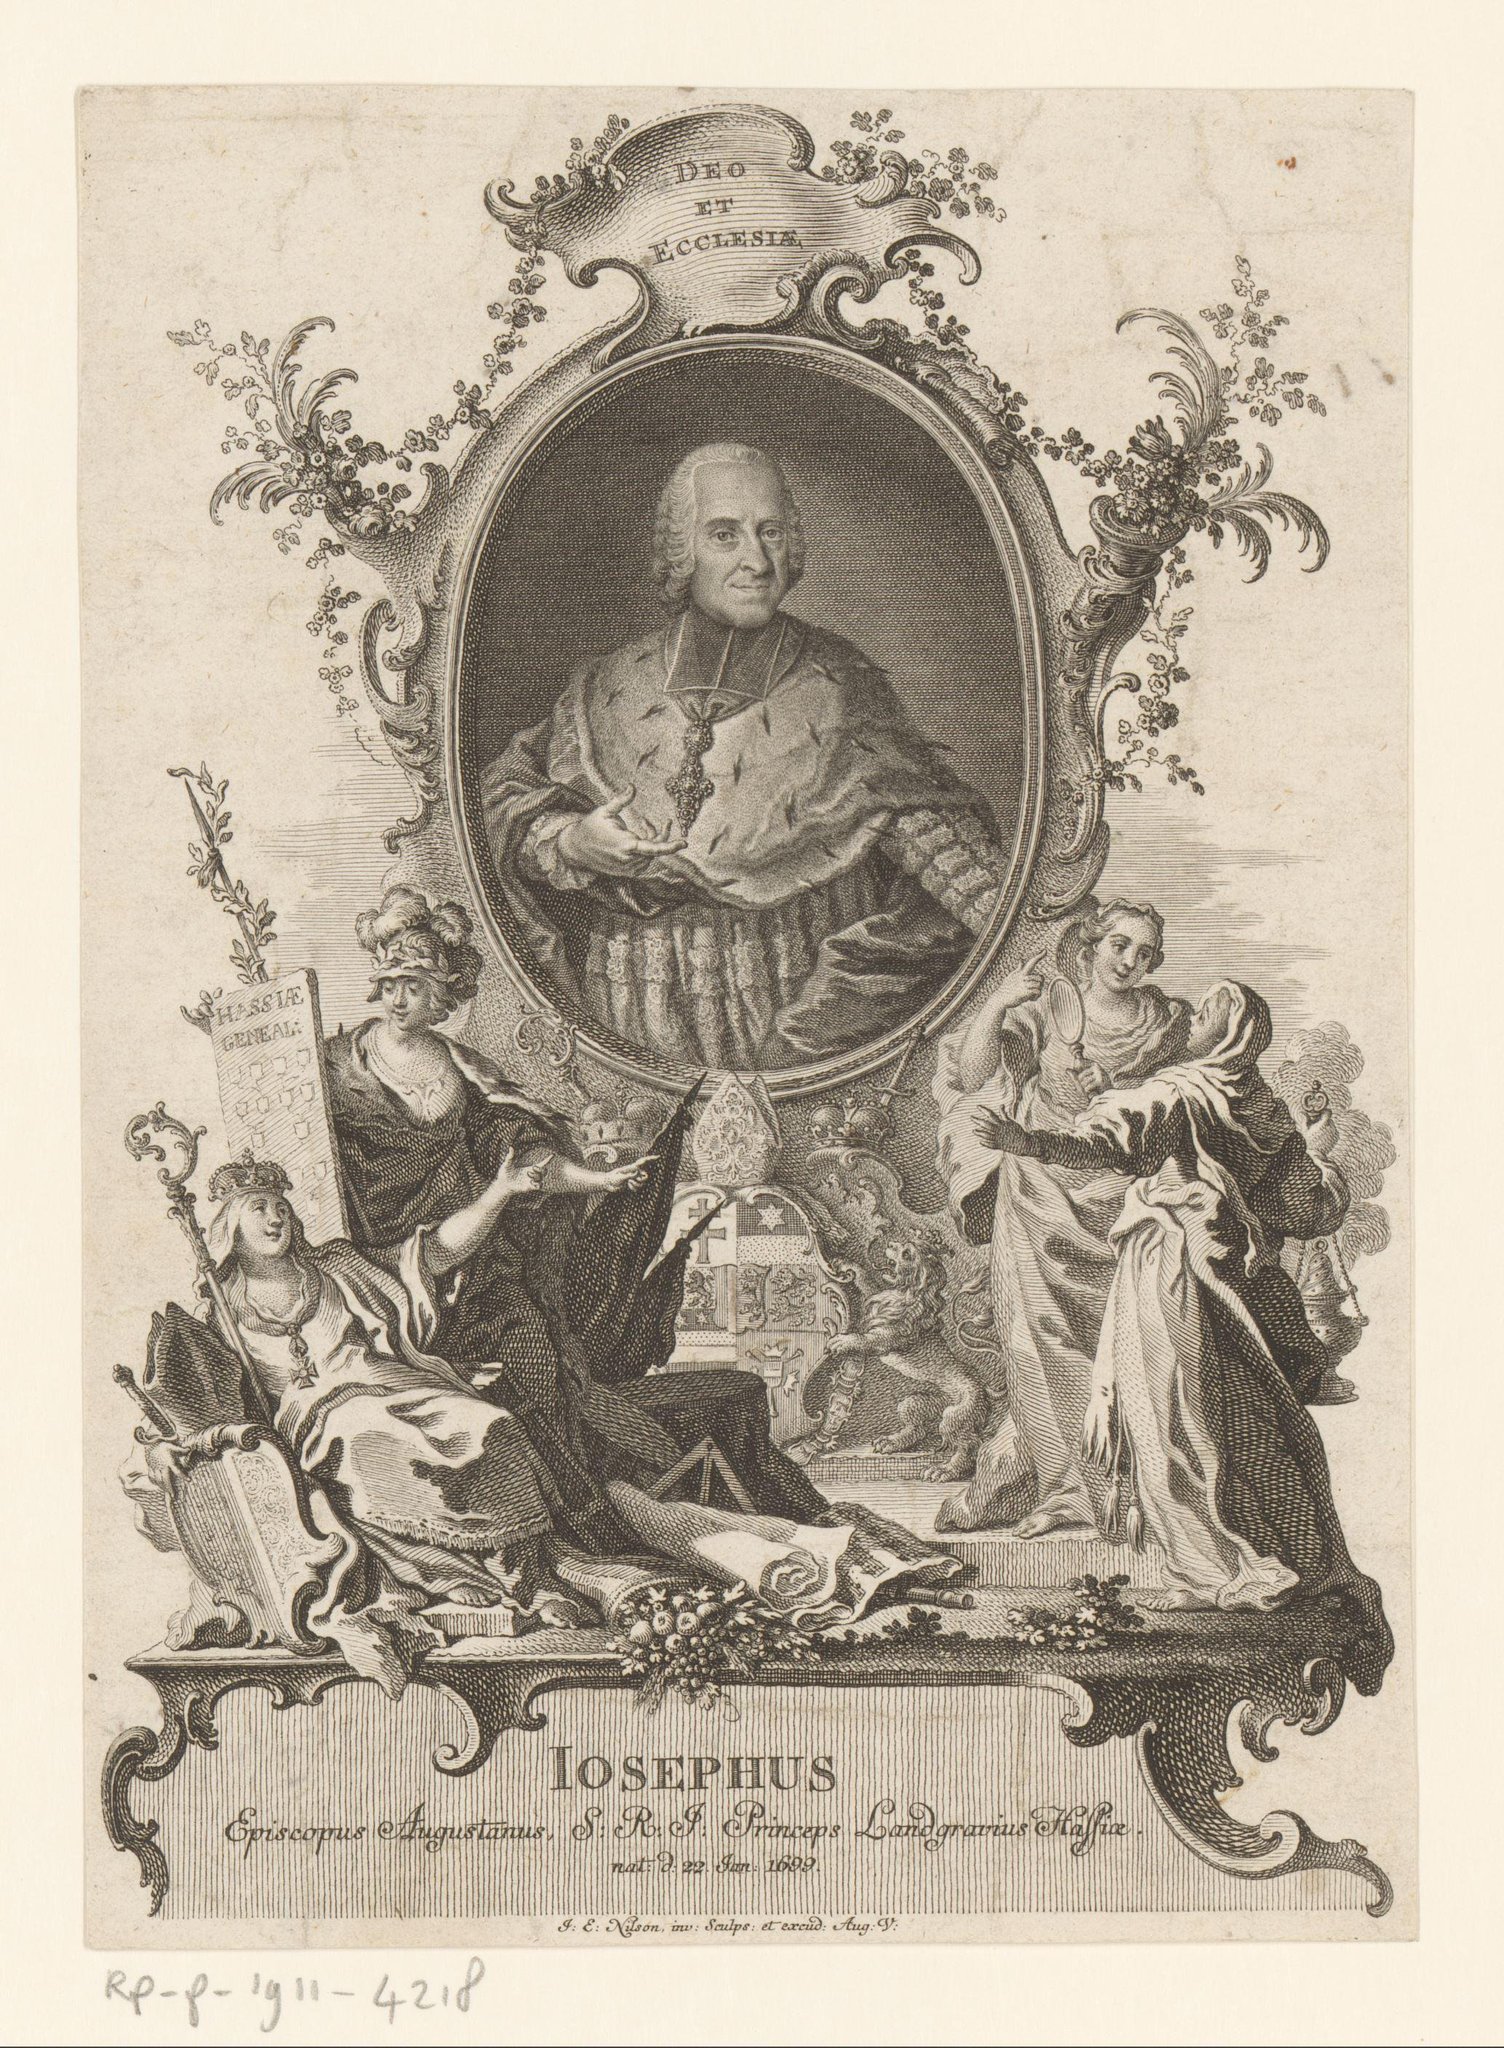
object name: print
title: Portret van Joseph Ignaz Philipp von Hessen-Darmstad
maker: johann esaias nilson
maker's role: draughtsman, print maker, publisher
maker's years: 1721-1788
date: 1731-1788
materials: paper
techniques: engraving, etching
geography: augsburg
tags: brussels, devotion, piety; 'divotione' (ripa), the liberal arts, 'artes liberales', historical persons, family, relationship, descent, armorial bearing, heraldry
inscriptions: collector's mark: Lugt 2228